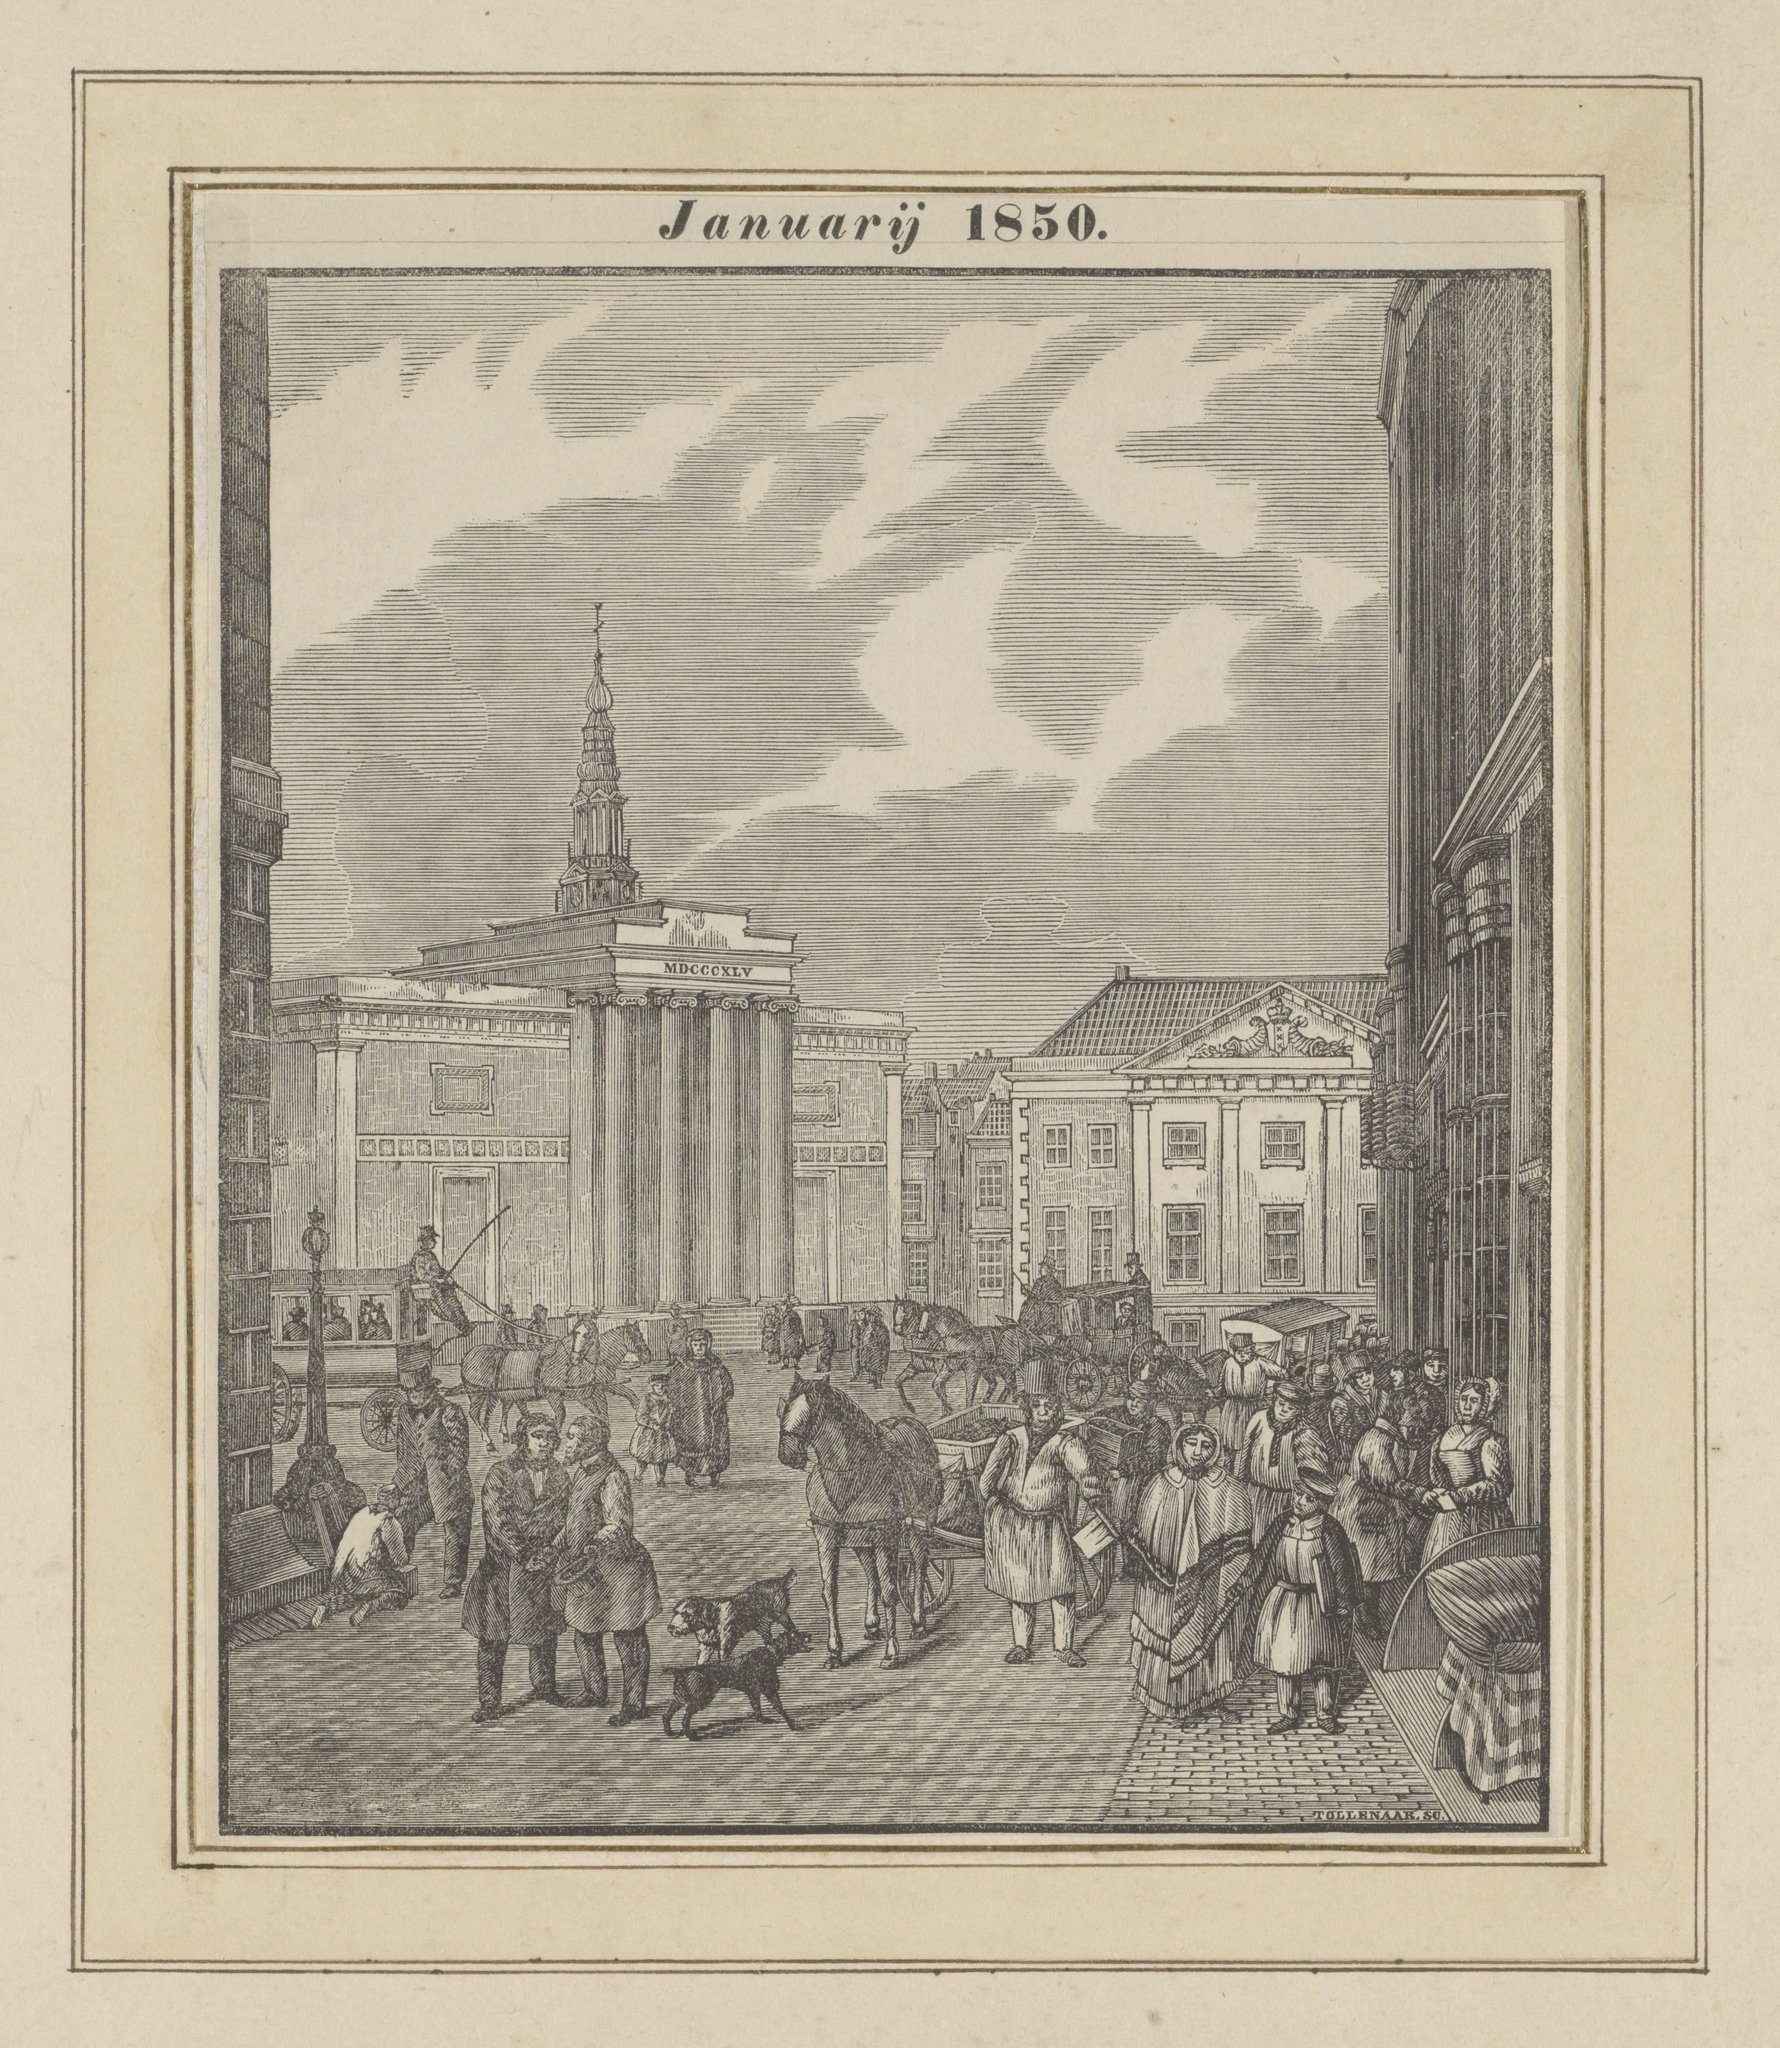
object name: print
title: Nieuwjaarswens van de Amsterdamse askarrenmannen voor het jaar 1850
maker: antonie vink tollenaar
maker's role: print maker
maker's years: 1805-1875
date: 1850-1852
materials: paper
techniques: letterpress printing, engraving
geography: netherlands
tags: square, place, circus, etc., garbage collection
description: Gezicht op de Dam te Amsterdam met de Beurs van Zocher en het Commandantshuis. Tussen het publiek de vuilnismannen met hun kar.